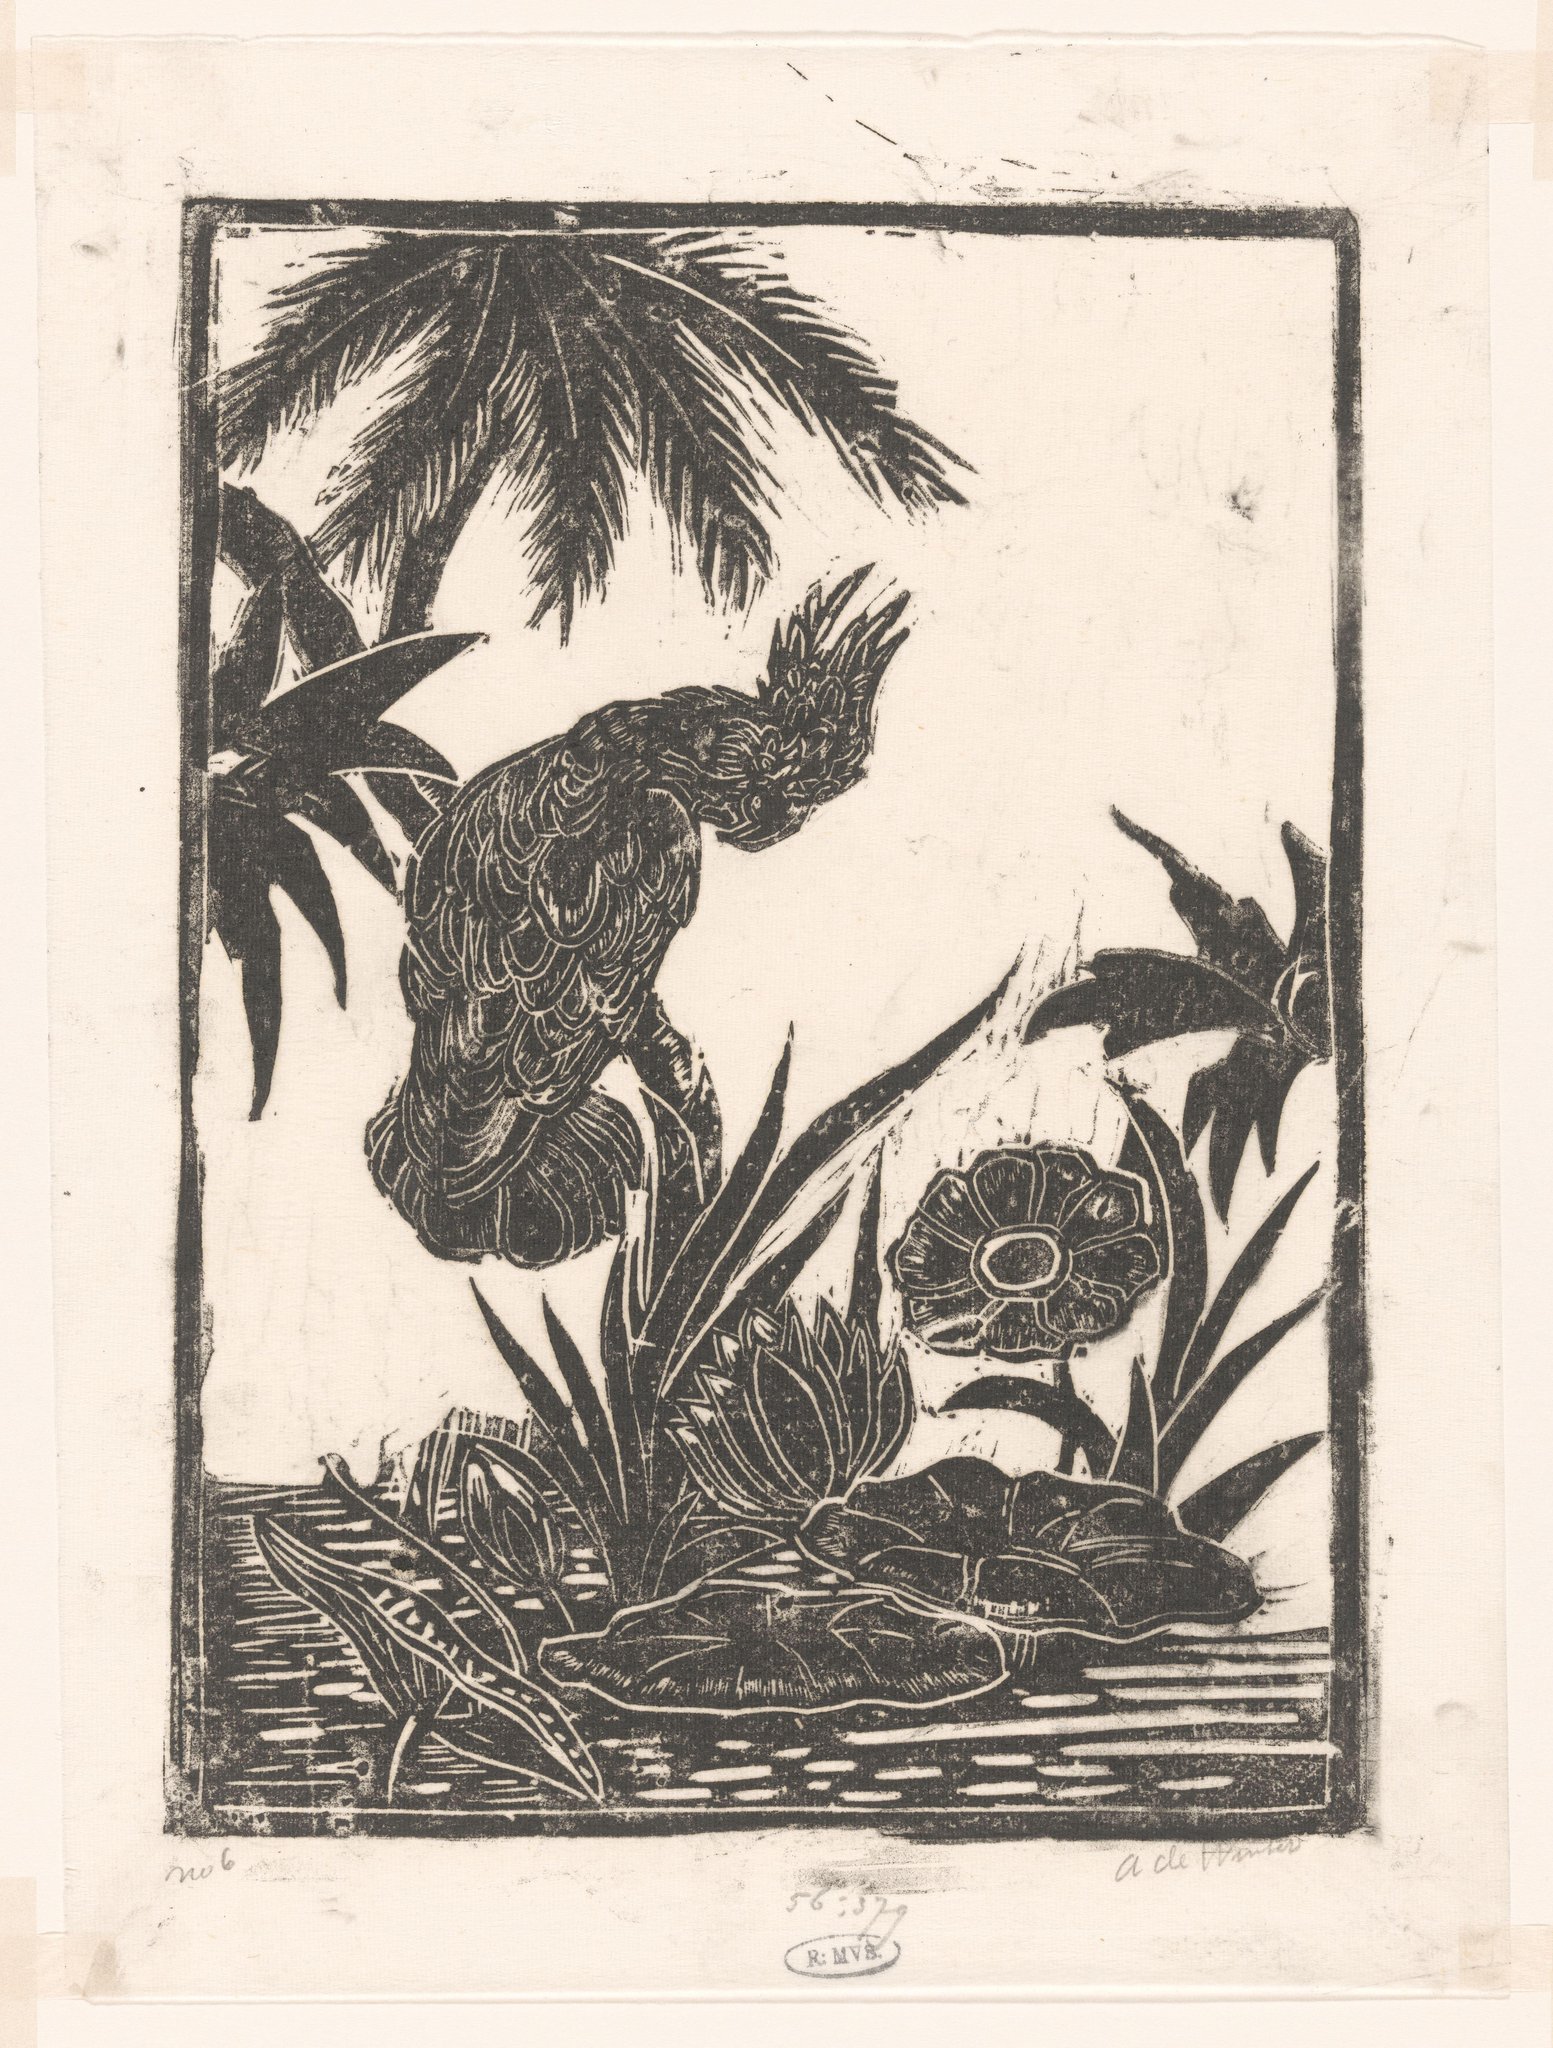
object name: print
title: Kaketoe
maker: janus de winter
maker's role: print maker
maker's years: 1882-1951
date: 1892-1951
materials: paper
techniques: linocut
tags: flowers: lily, ornamental birds: cockatoo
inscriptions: collector's mark: Lugt 2228